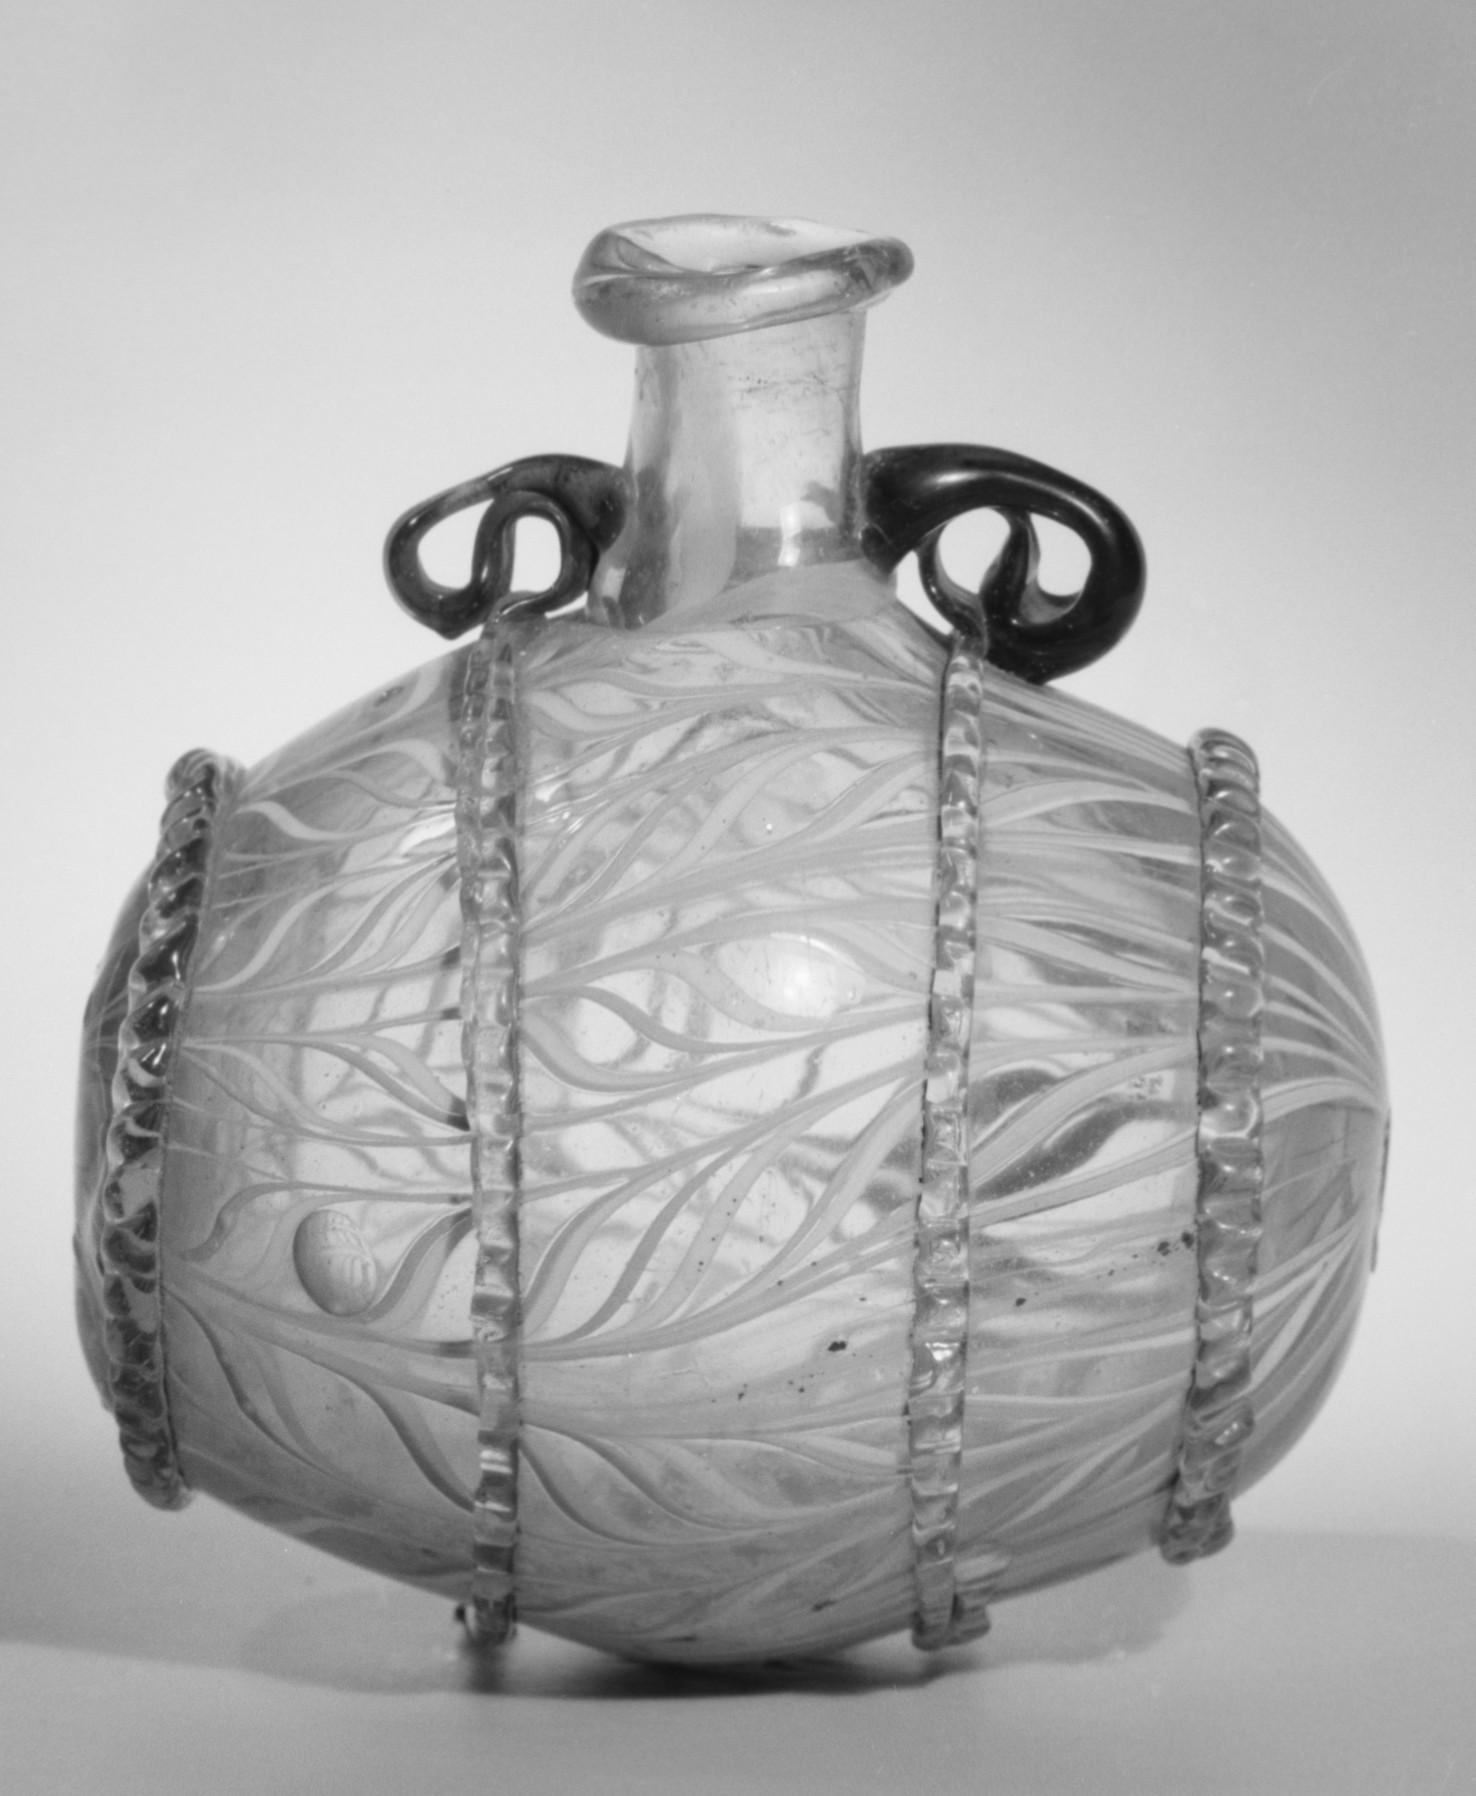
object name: flask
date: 1601-1800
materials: glass